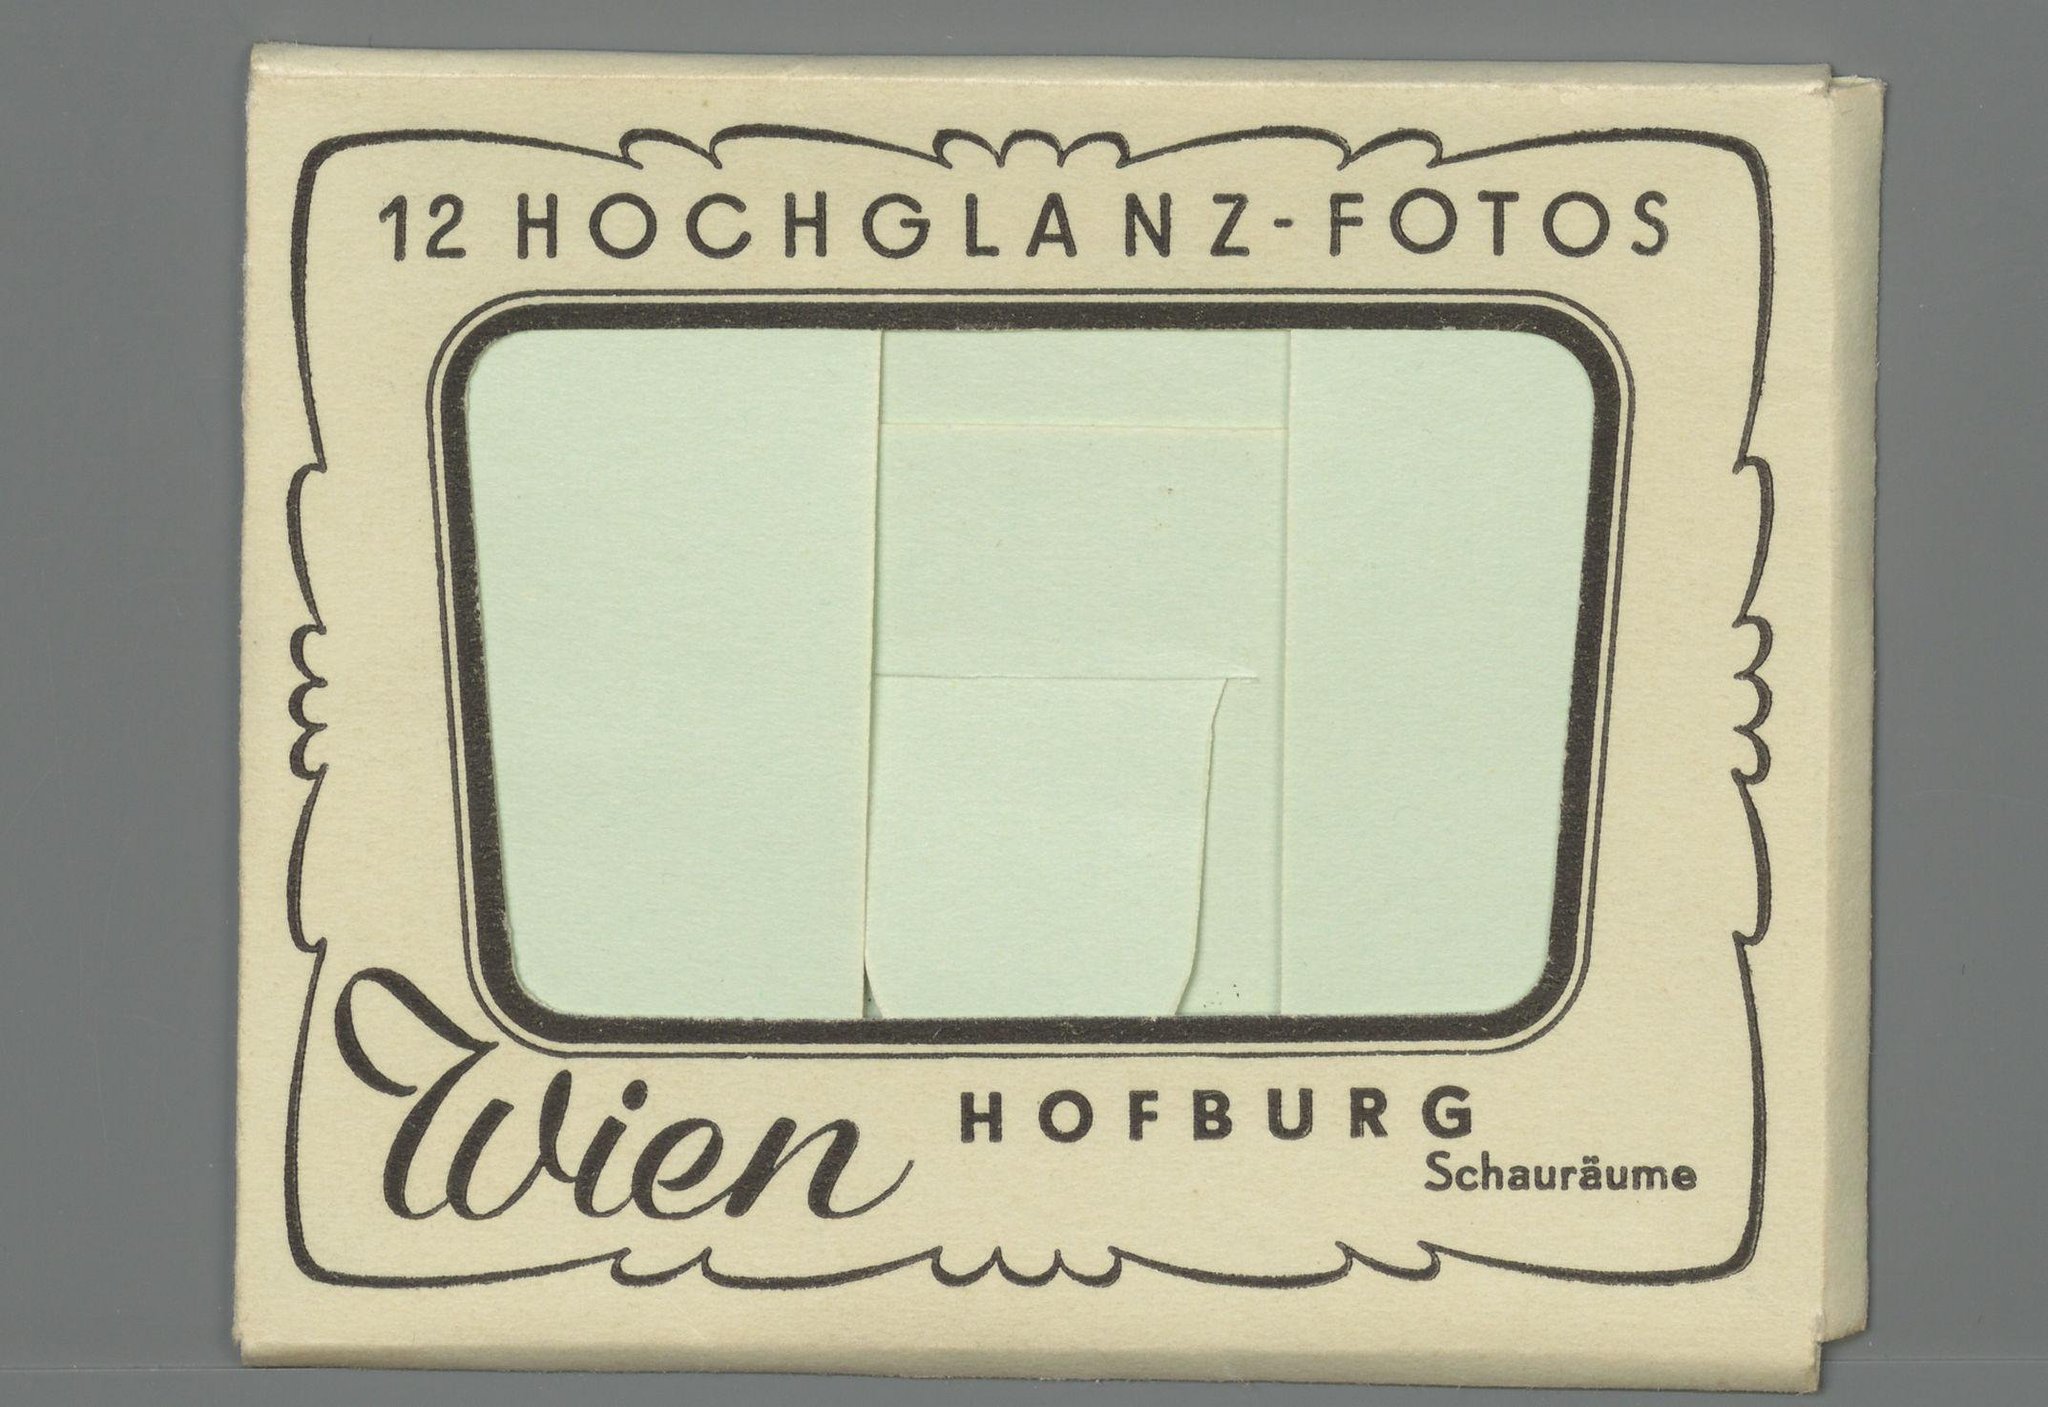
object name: wrapper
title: Omslag voor twaalf foto's met gezichten van de Hofburg te Wenen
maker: Anonymous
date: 1950-1960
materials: cardboard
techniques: printing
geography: vienna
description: Het omslag is bedoeld voor twaalf foto's. In dit exemplaar zijn elf foto's aangetroffen.